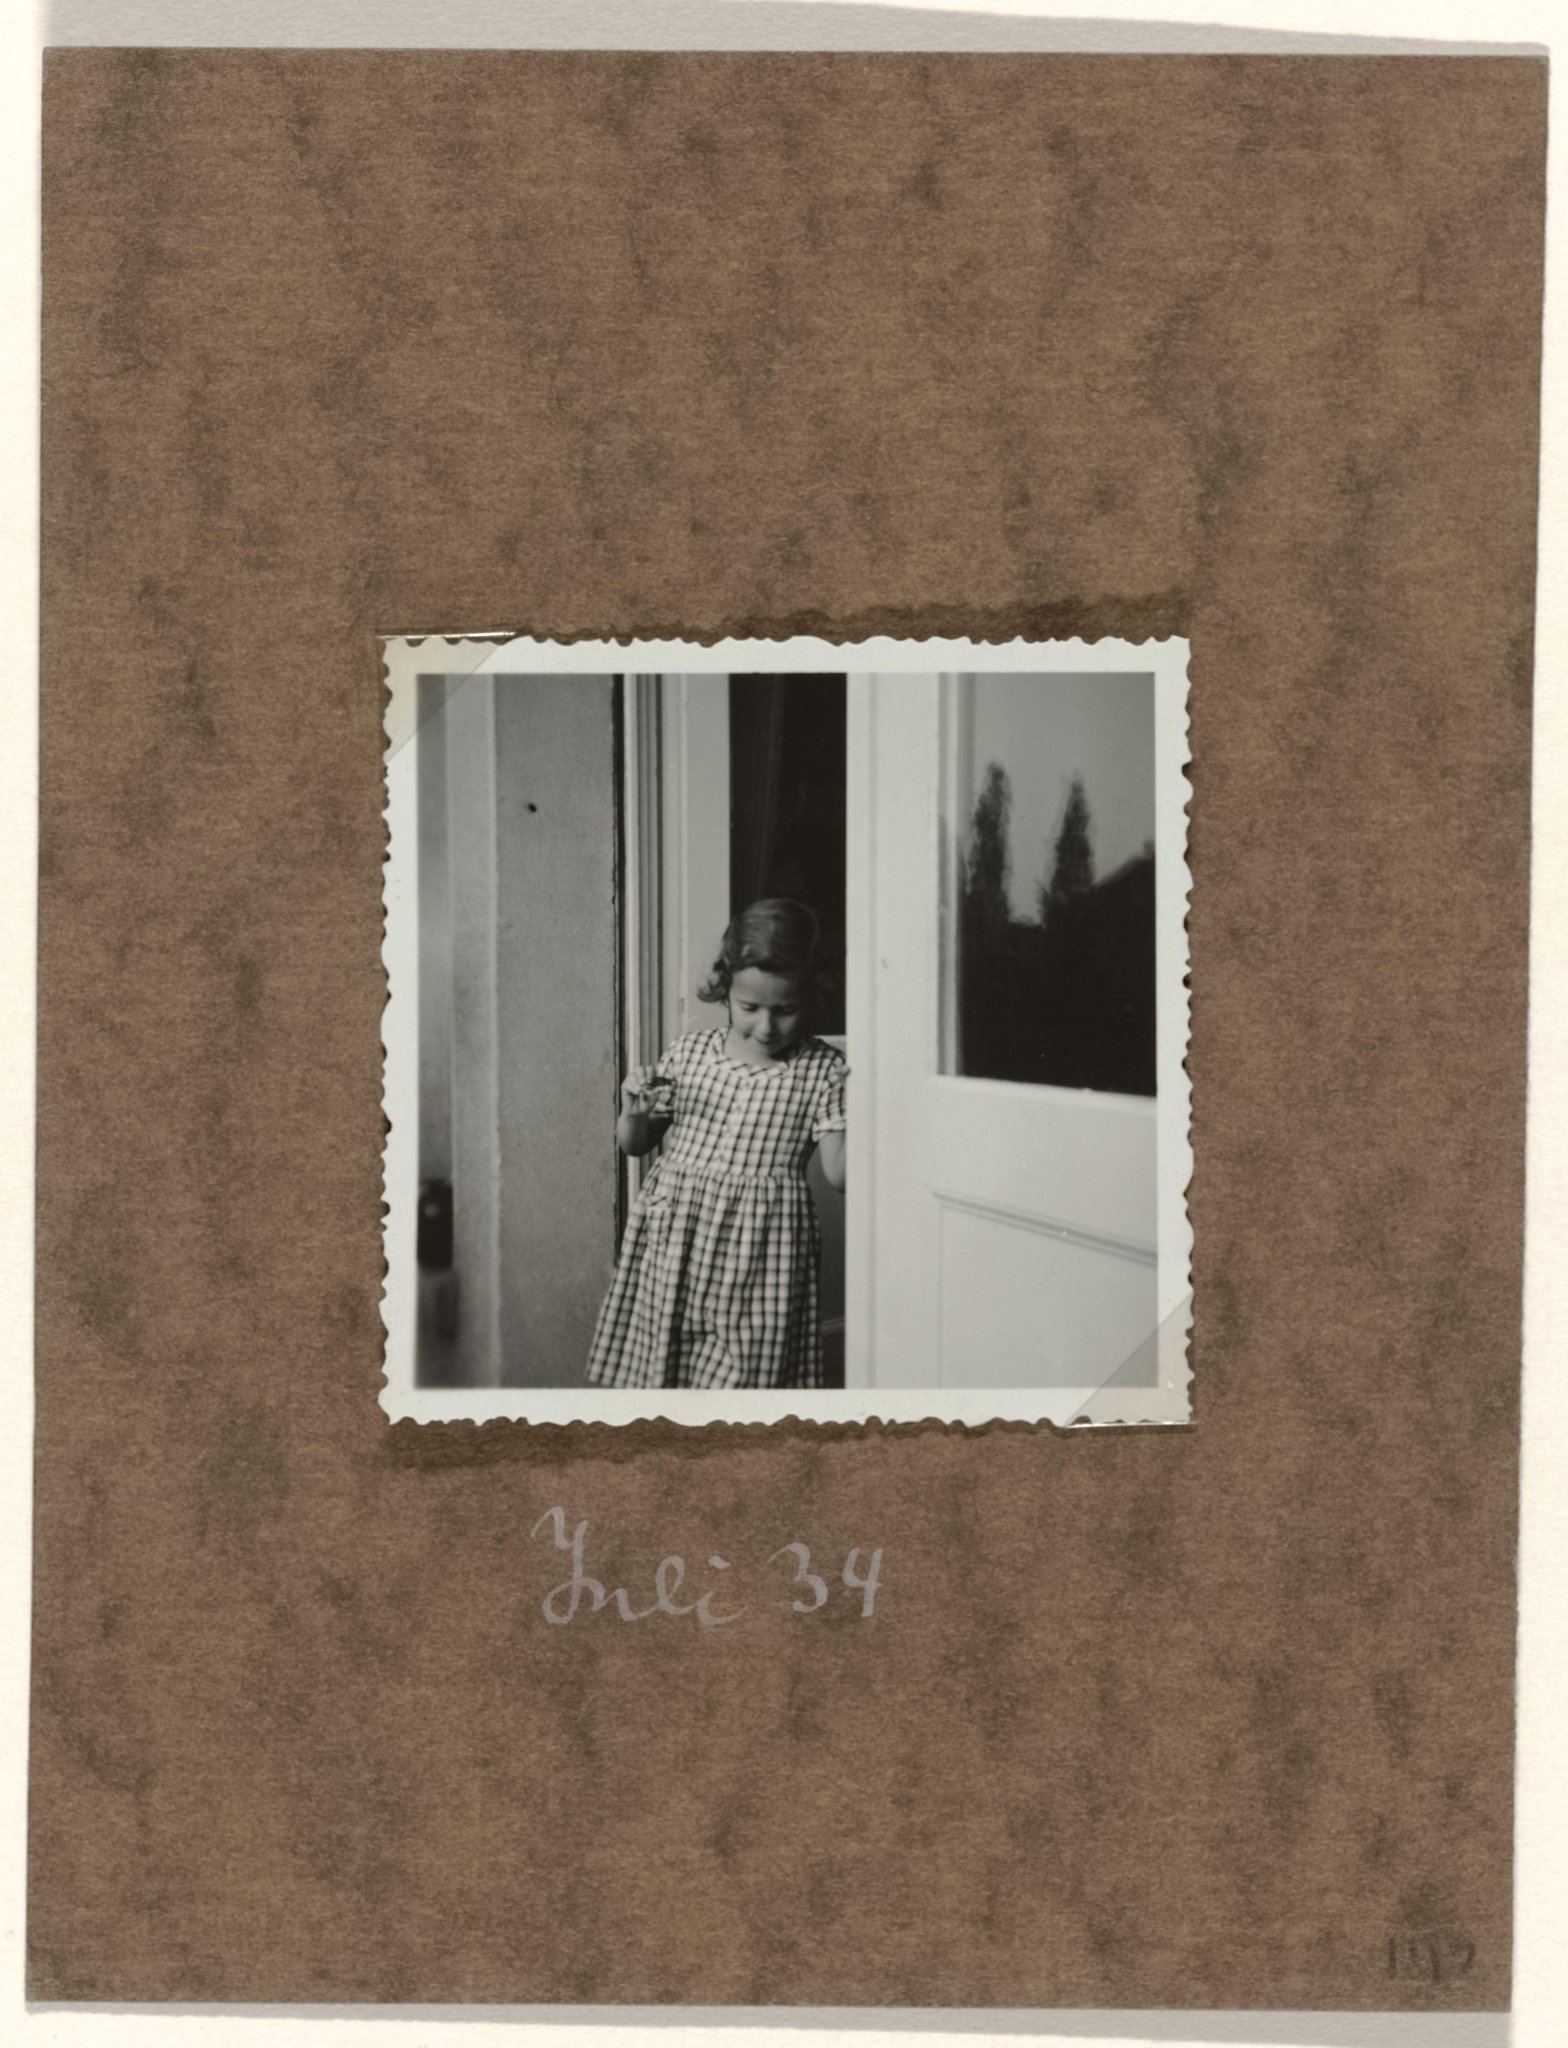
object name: photograph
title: Isabel Wachenheimer in een deuropening, juli 1934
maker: Anonymous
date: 1907-1934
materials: photographic support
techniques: gelatin silver print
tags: leiden, isabel wachenheimer-elon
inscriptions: date: ‘Juli 34’